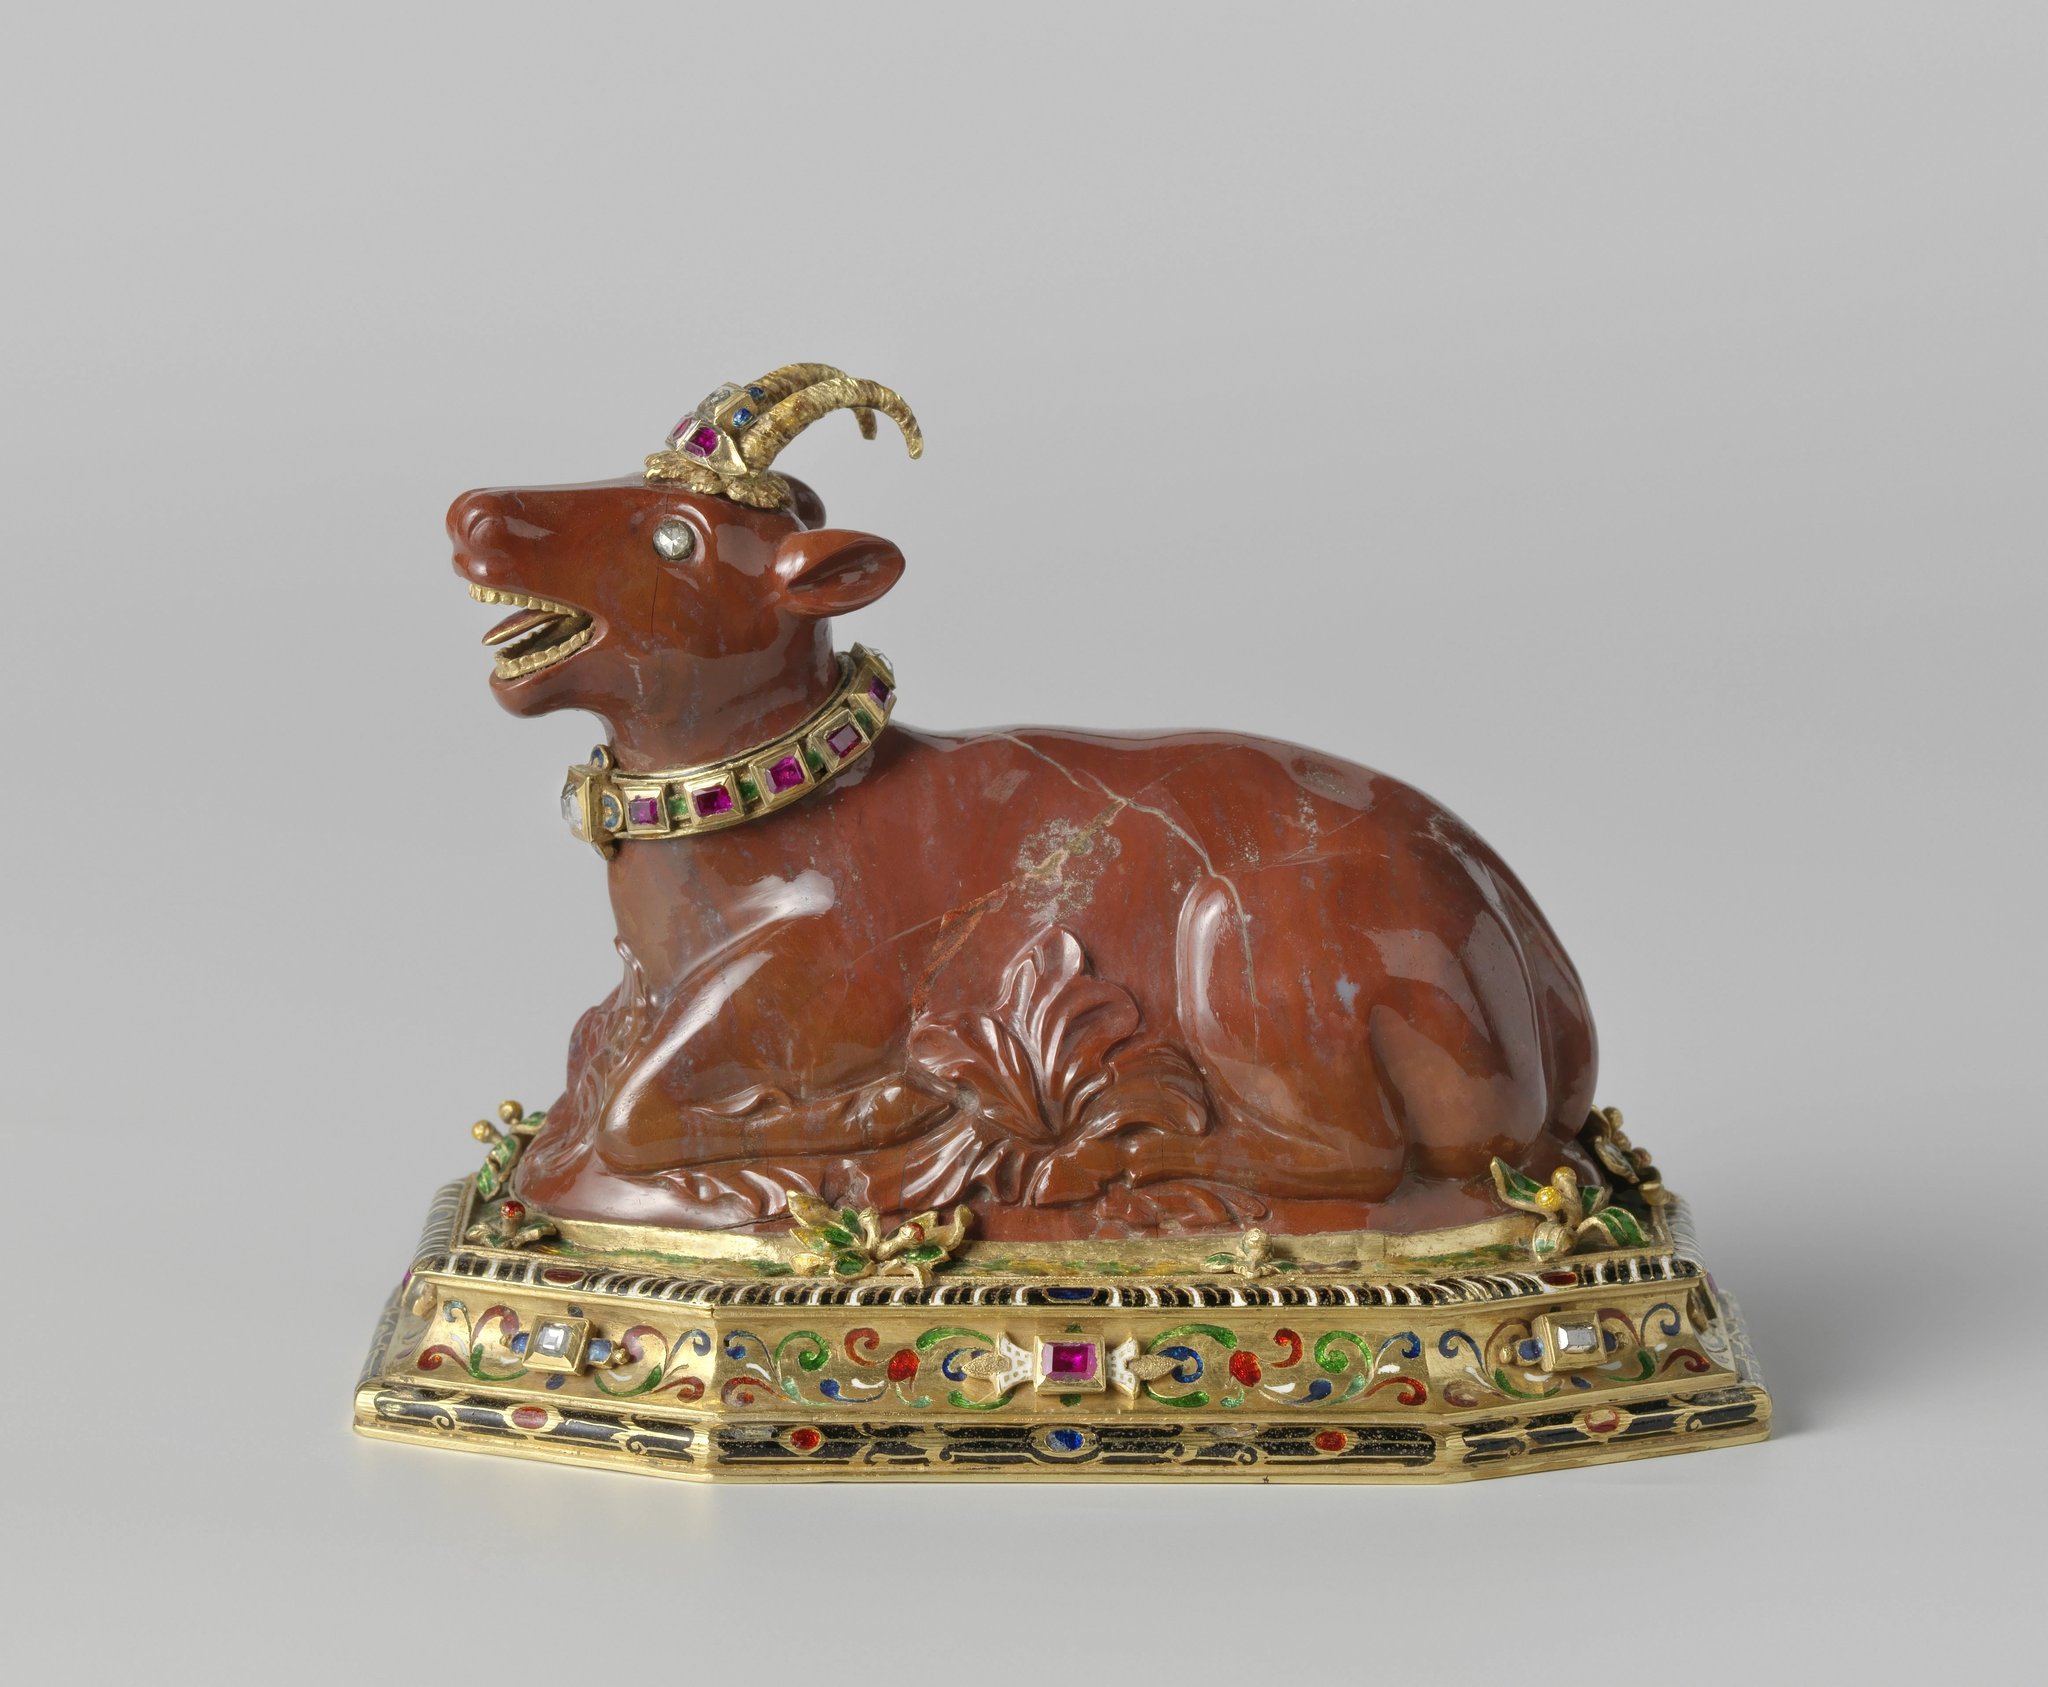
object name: jewellery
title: Ibex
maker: Anonymous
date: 1575-1600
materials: diamond, gold, jasper, gemstone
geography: germany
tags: hoofed animals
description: Liggende steenbok op postament. Rood-bruine jaspis, de hoorns en halsband zijn bezet met diamanten en robijnen. Achtzijdig voetstuk van goud met verzonken email-translucide en in het midden van elke zijde een opgelegde edelsteen in vierkante vatting.